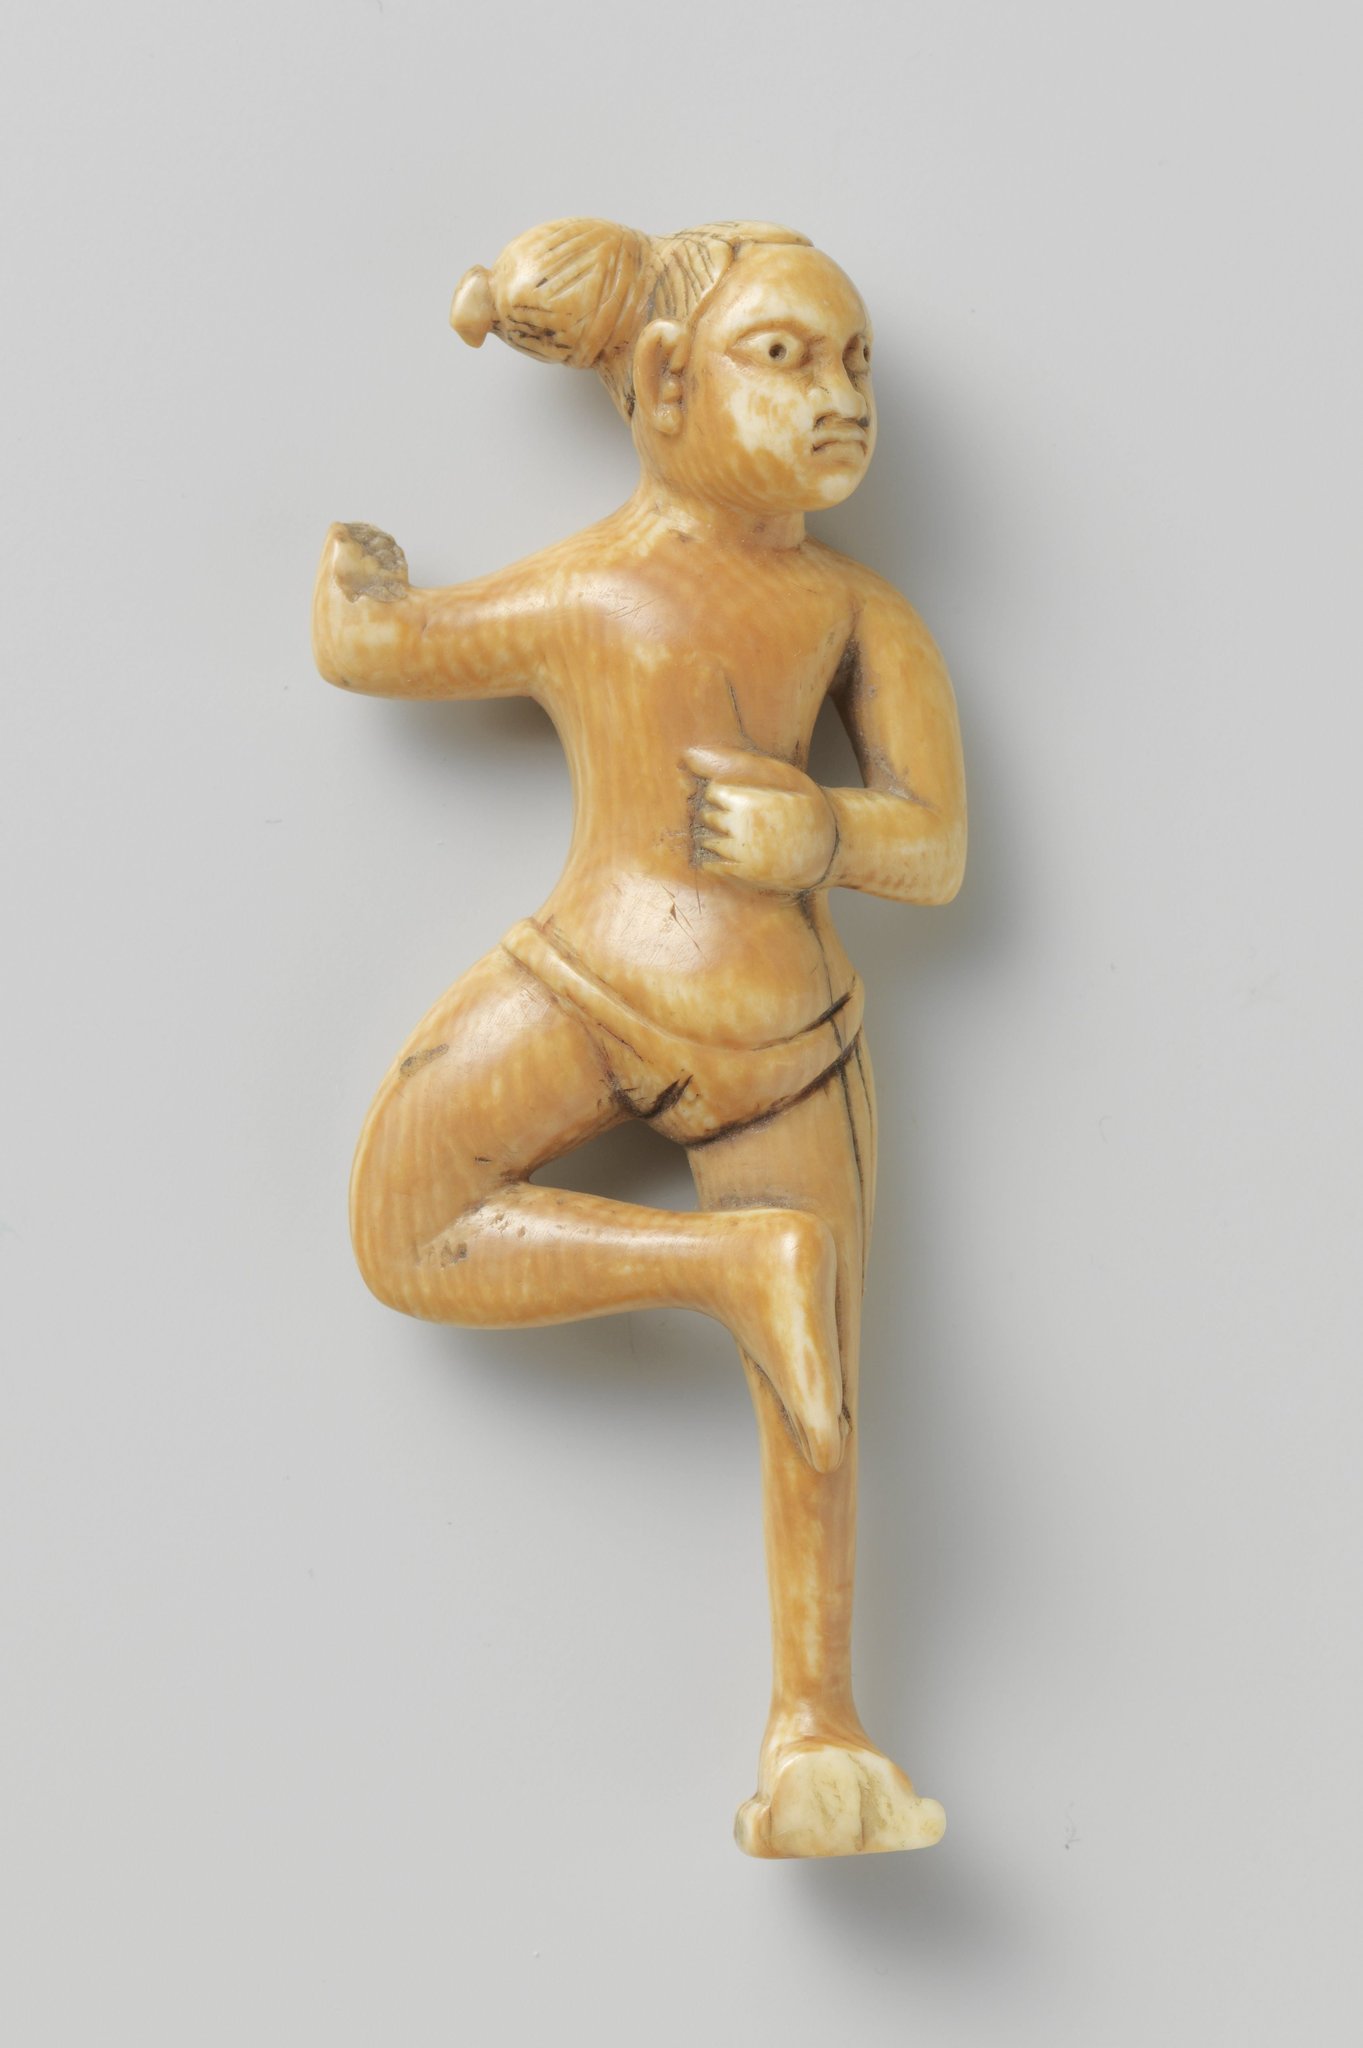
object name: sculpture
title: Beeldhouwwerk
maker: Anonymous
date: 1750-1900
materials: ivory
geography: south india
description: Wellicht een asceet, de linkerhand tegen het lichaam gehouden, rechterbovenarm opgeheven, rechteronderarm afgebroken, rechtervoet op knie van het linkerbeen.